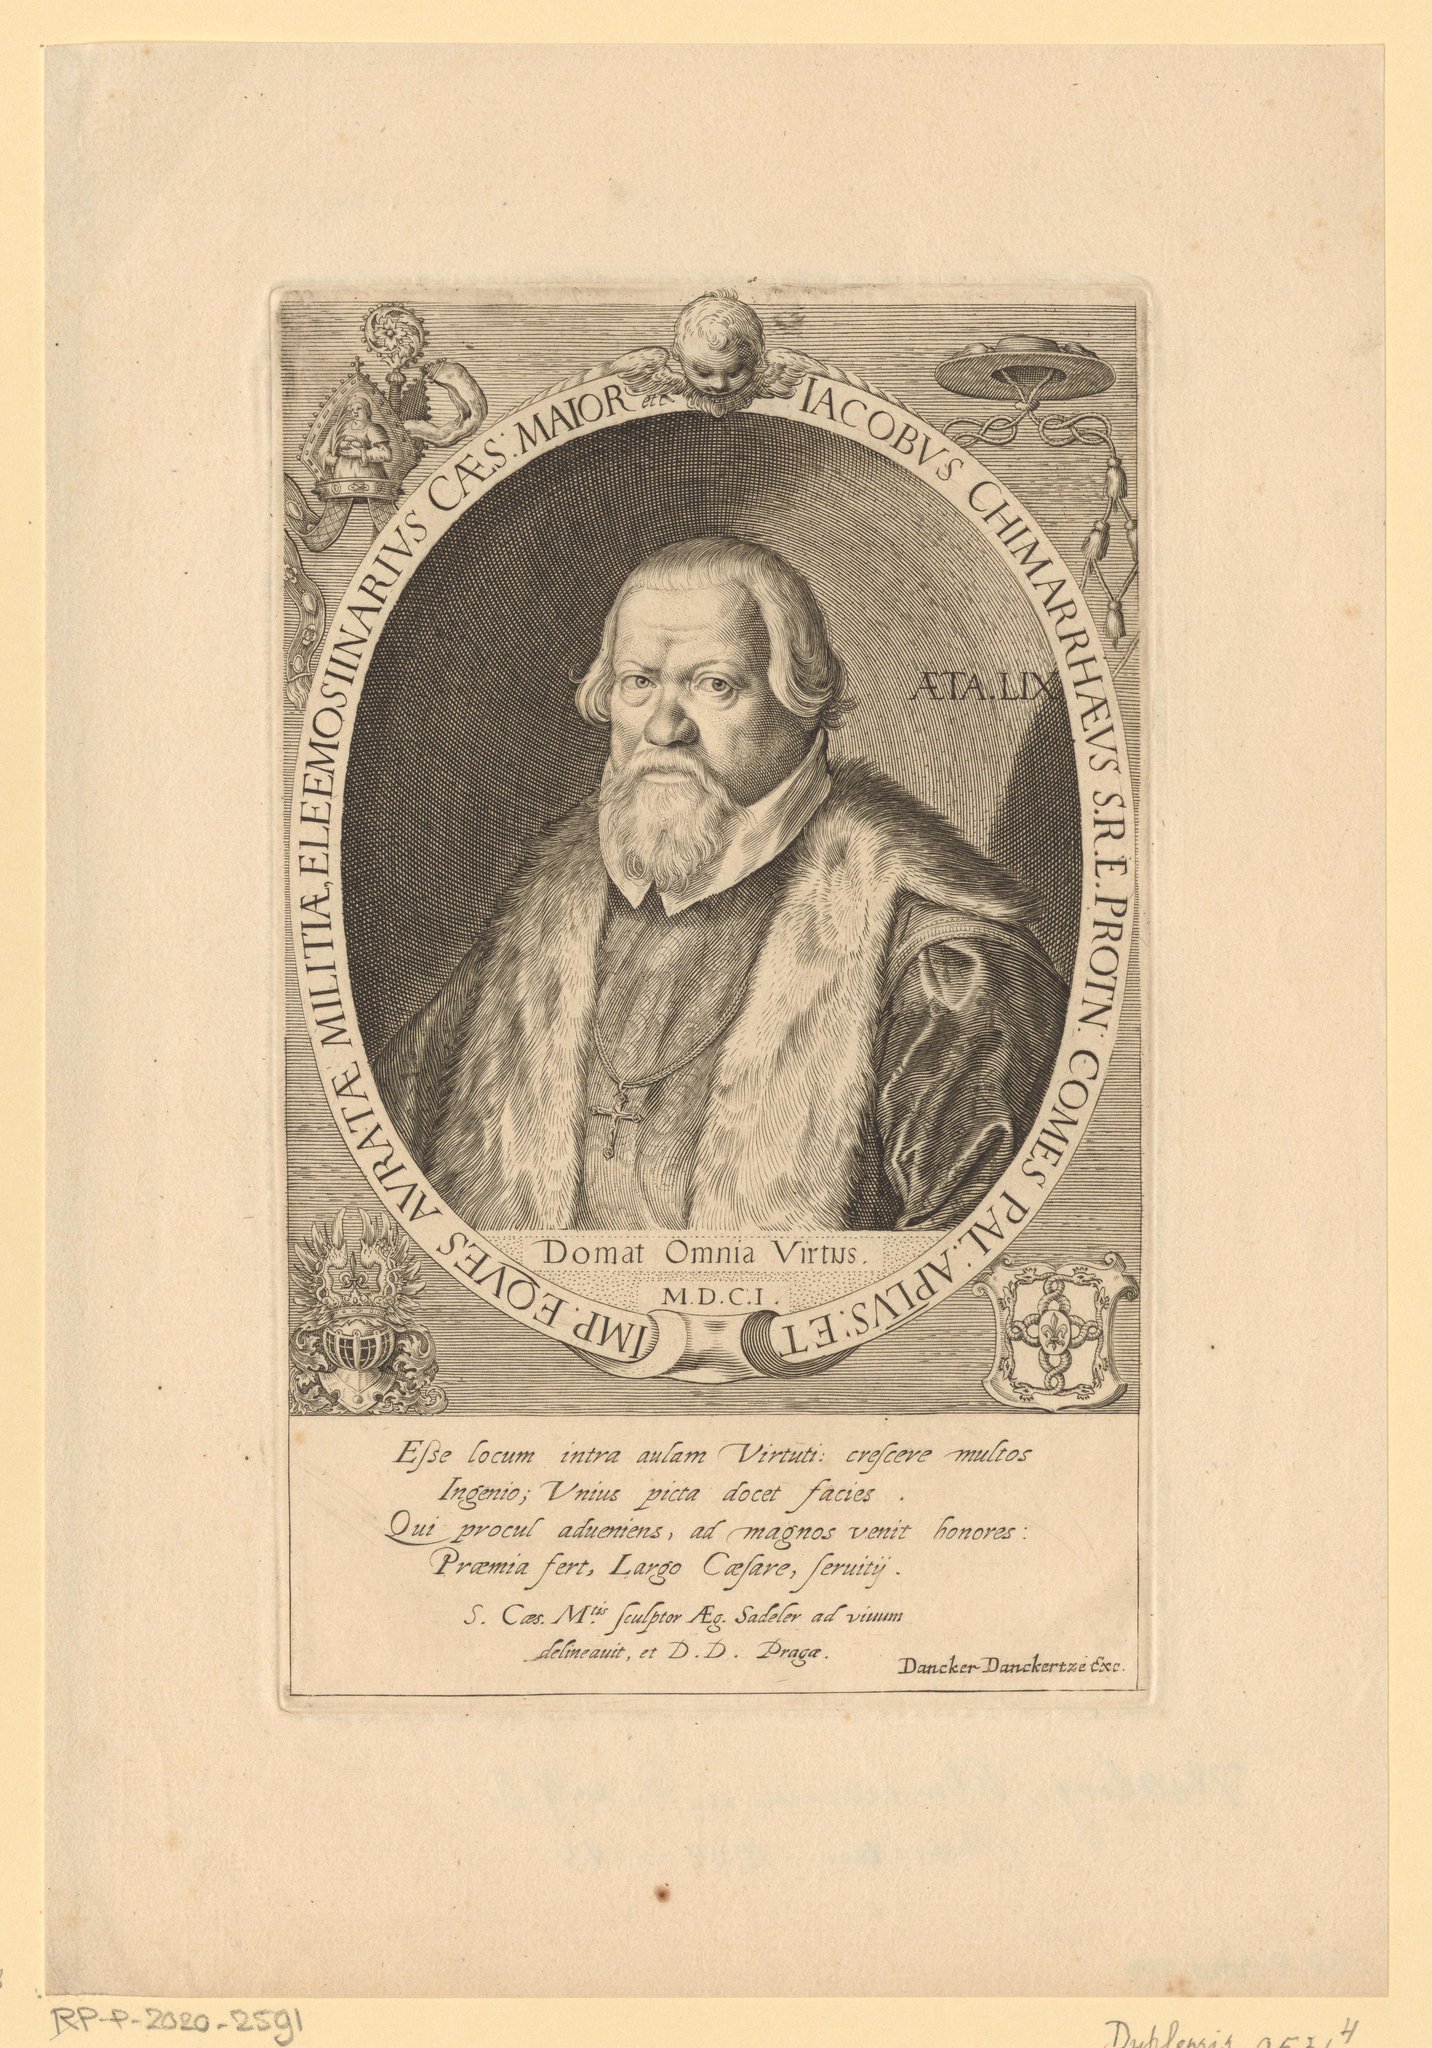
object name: print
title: Portret van Jacob Chimarrhaeus op 59-jarige leeftijd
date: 1654-1666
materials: paper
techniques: engraving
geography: prague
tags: jacob chimarrhaeus, historical persons